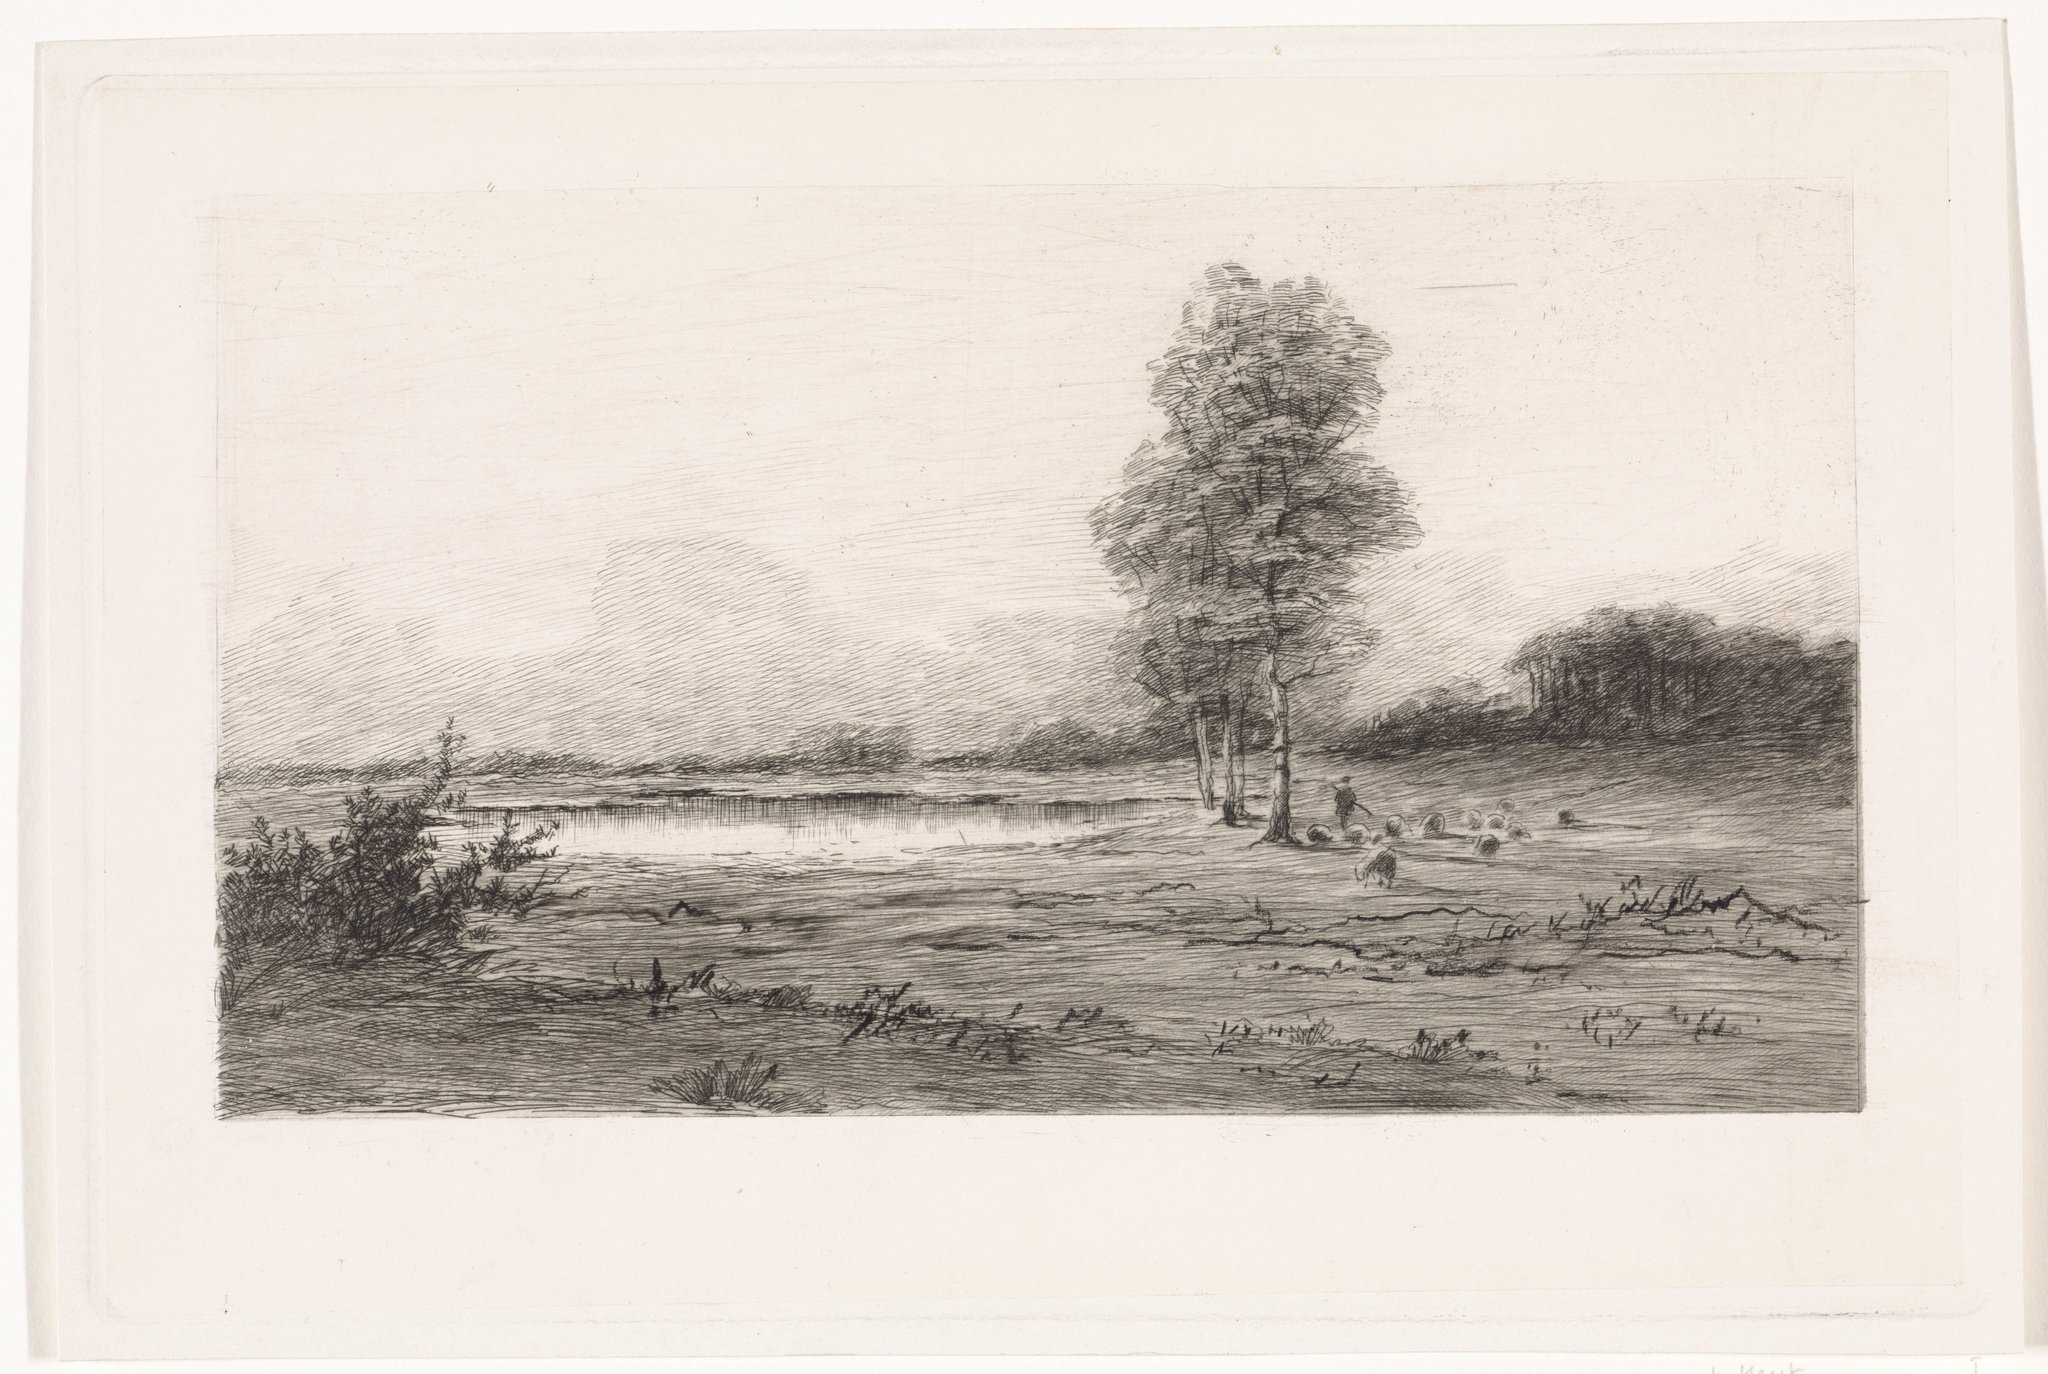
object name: print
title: Landschap met waterplas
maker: elias stark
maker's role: draughtsman, print maker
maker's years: 1849-1933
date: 1801-1891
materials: chalk, paper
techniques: etching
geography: nieuwer-amstel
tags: herding, herdsman, herdswoman, shepherd, shepherdess, cowherd, etc., pond, pool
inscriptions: collector's mark: Lugt 2228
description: Landschap met een waterplas. Bij enkele bomen staat een herder met zijn schapen.